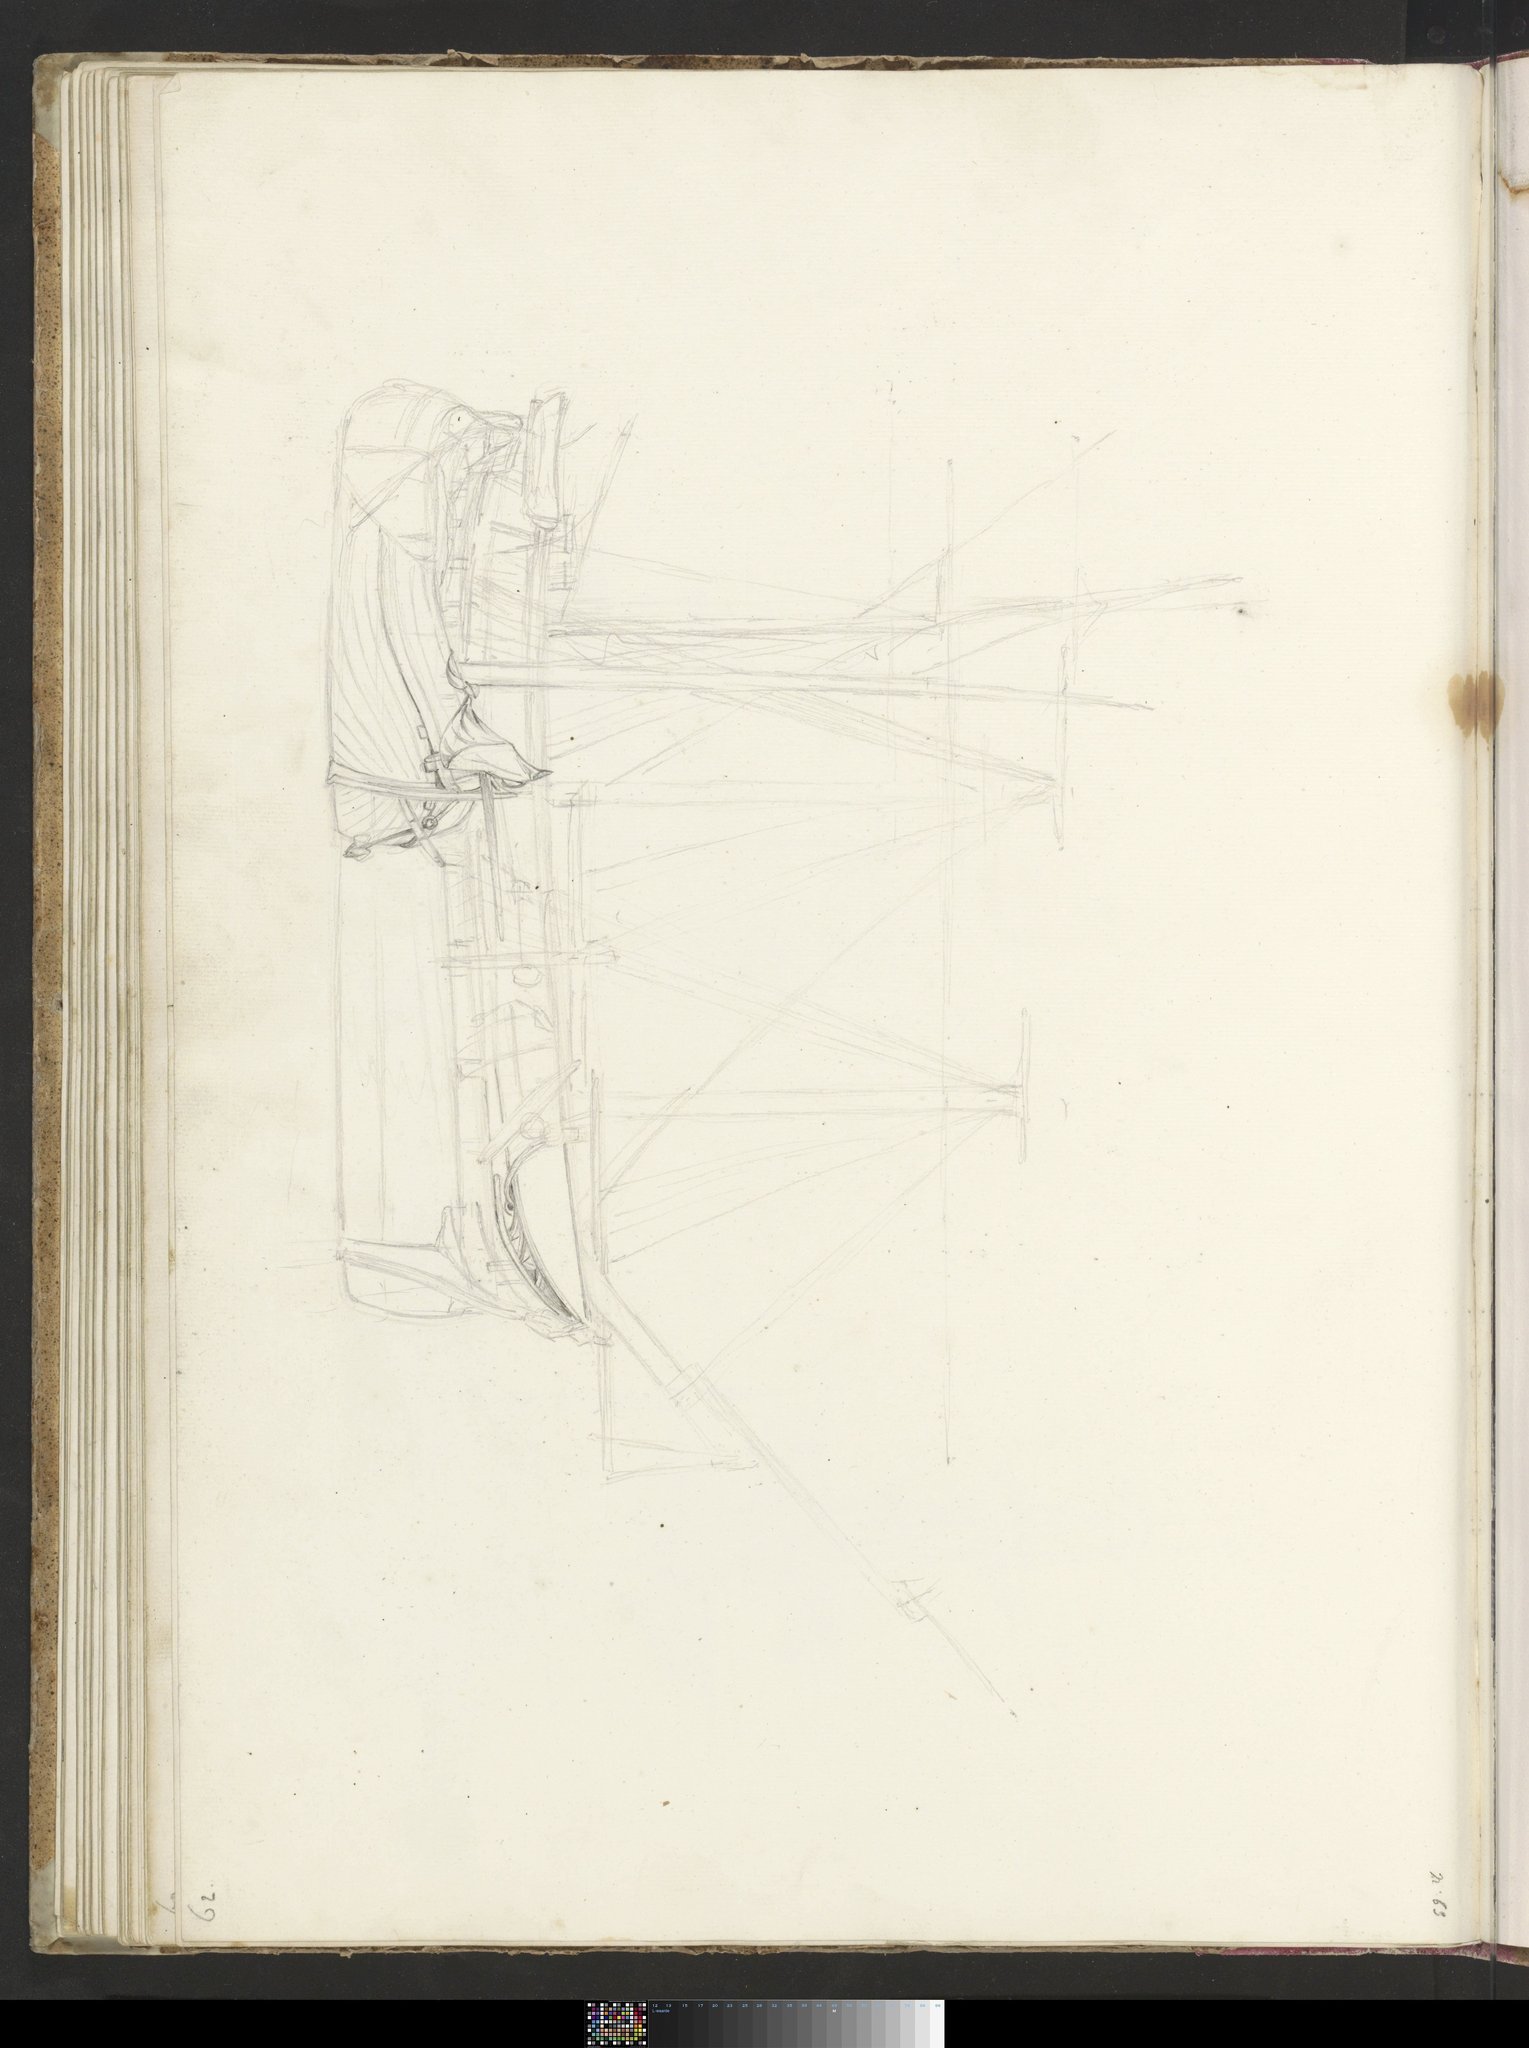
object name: sketchbook leaf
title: Zeilschepen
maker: johannes christiaan schotel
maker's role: draughtsman, painter, print maker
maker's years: 1787-1838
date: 1797-1838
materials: paper, pencil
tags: sailing-ship, sailing-boat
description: Blad 62 verso uit een schetsboek met 65 bladen.